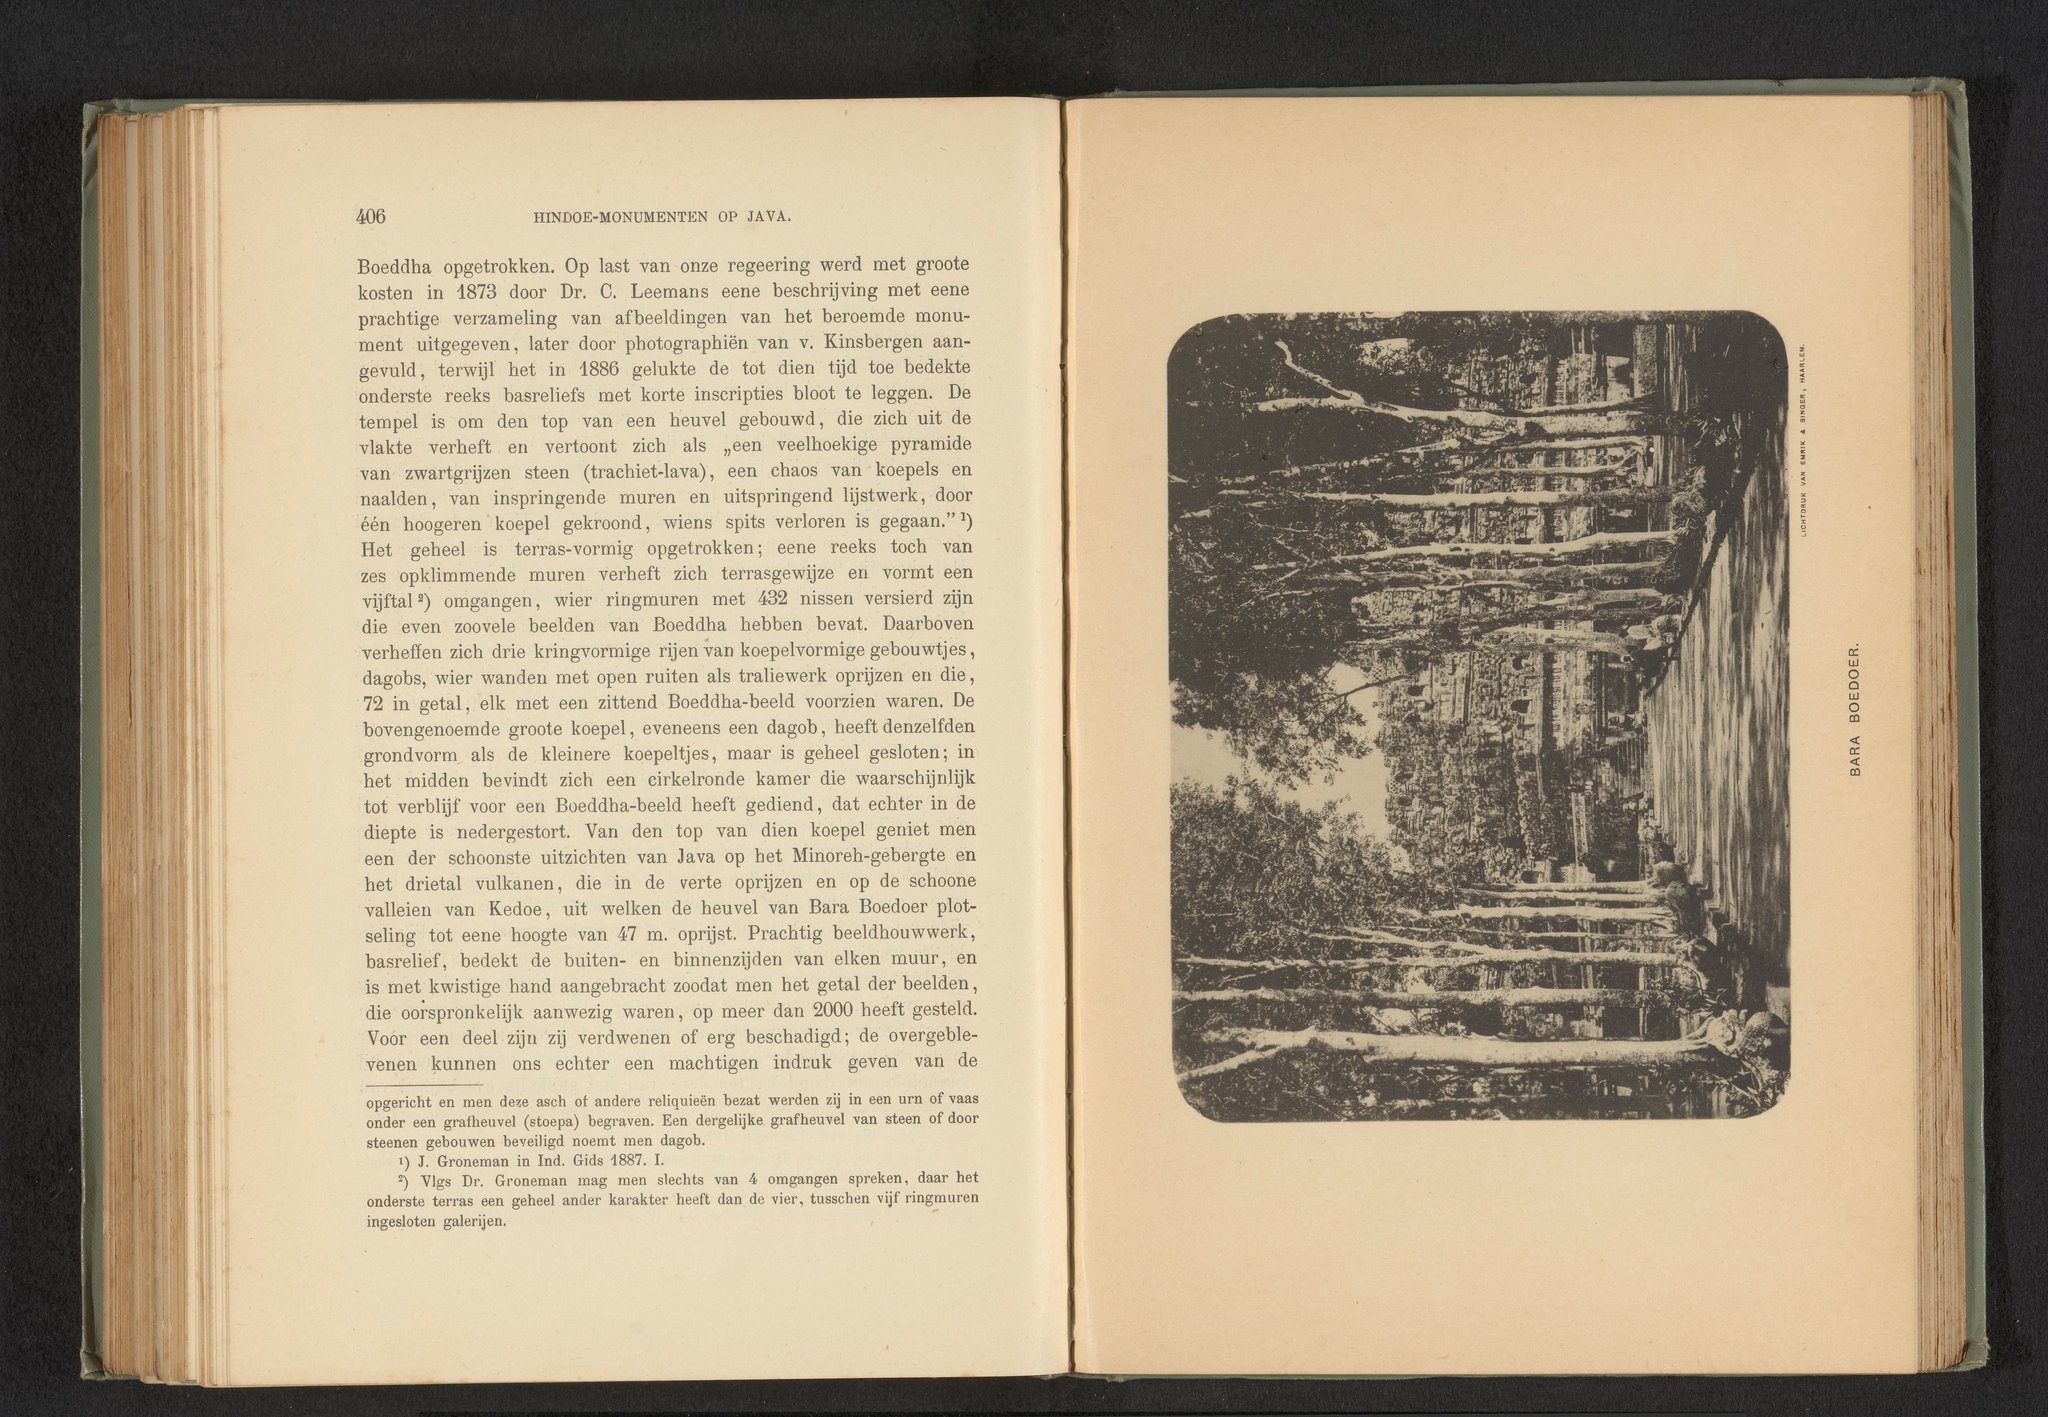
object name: page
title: Gezicht op de Borobudur op Java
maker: Anonymous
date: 1883-1894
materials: paper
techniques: photograph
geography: java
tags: temple, shrine ~ non-christian religions